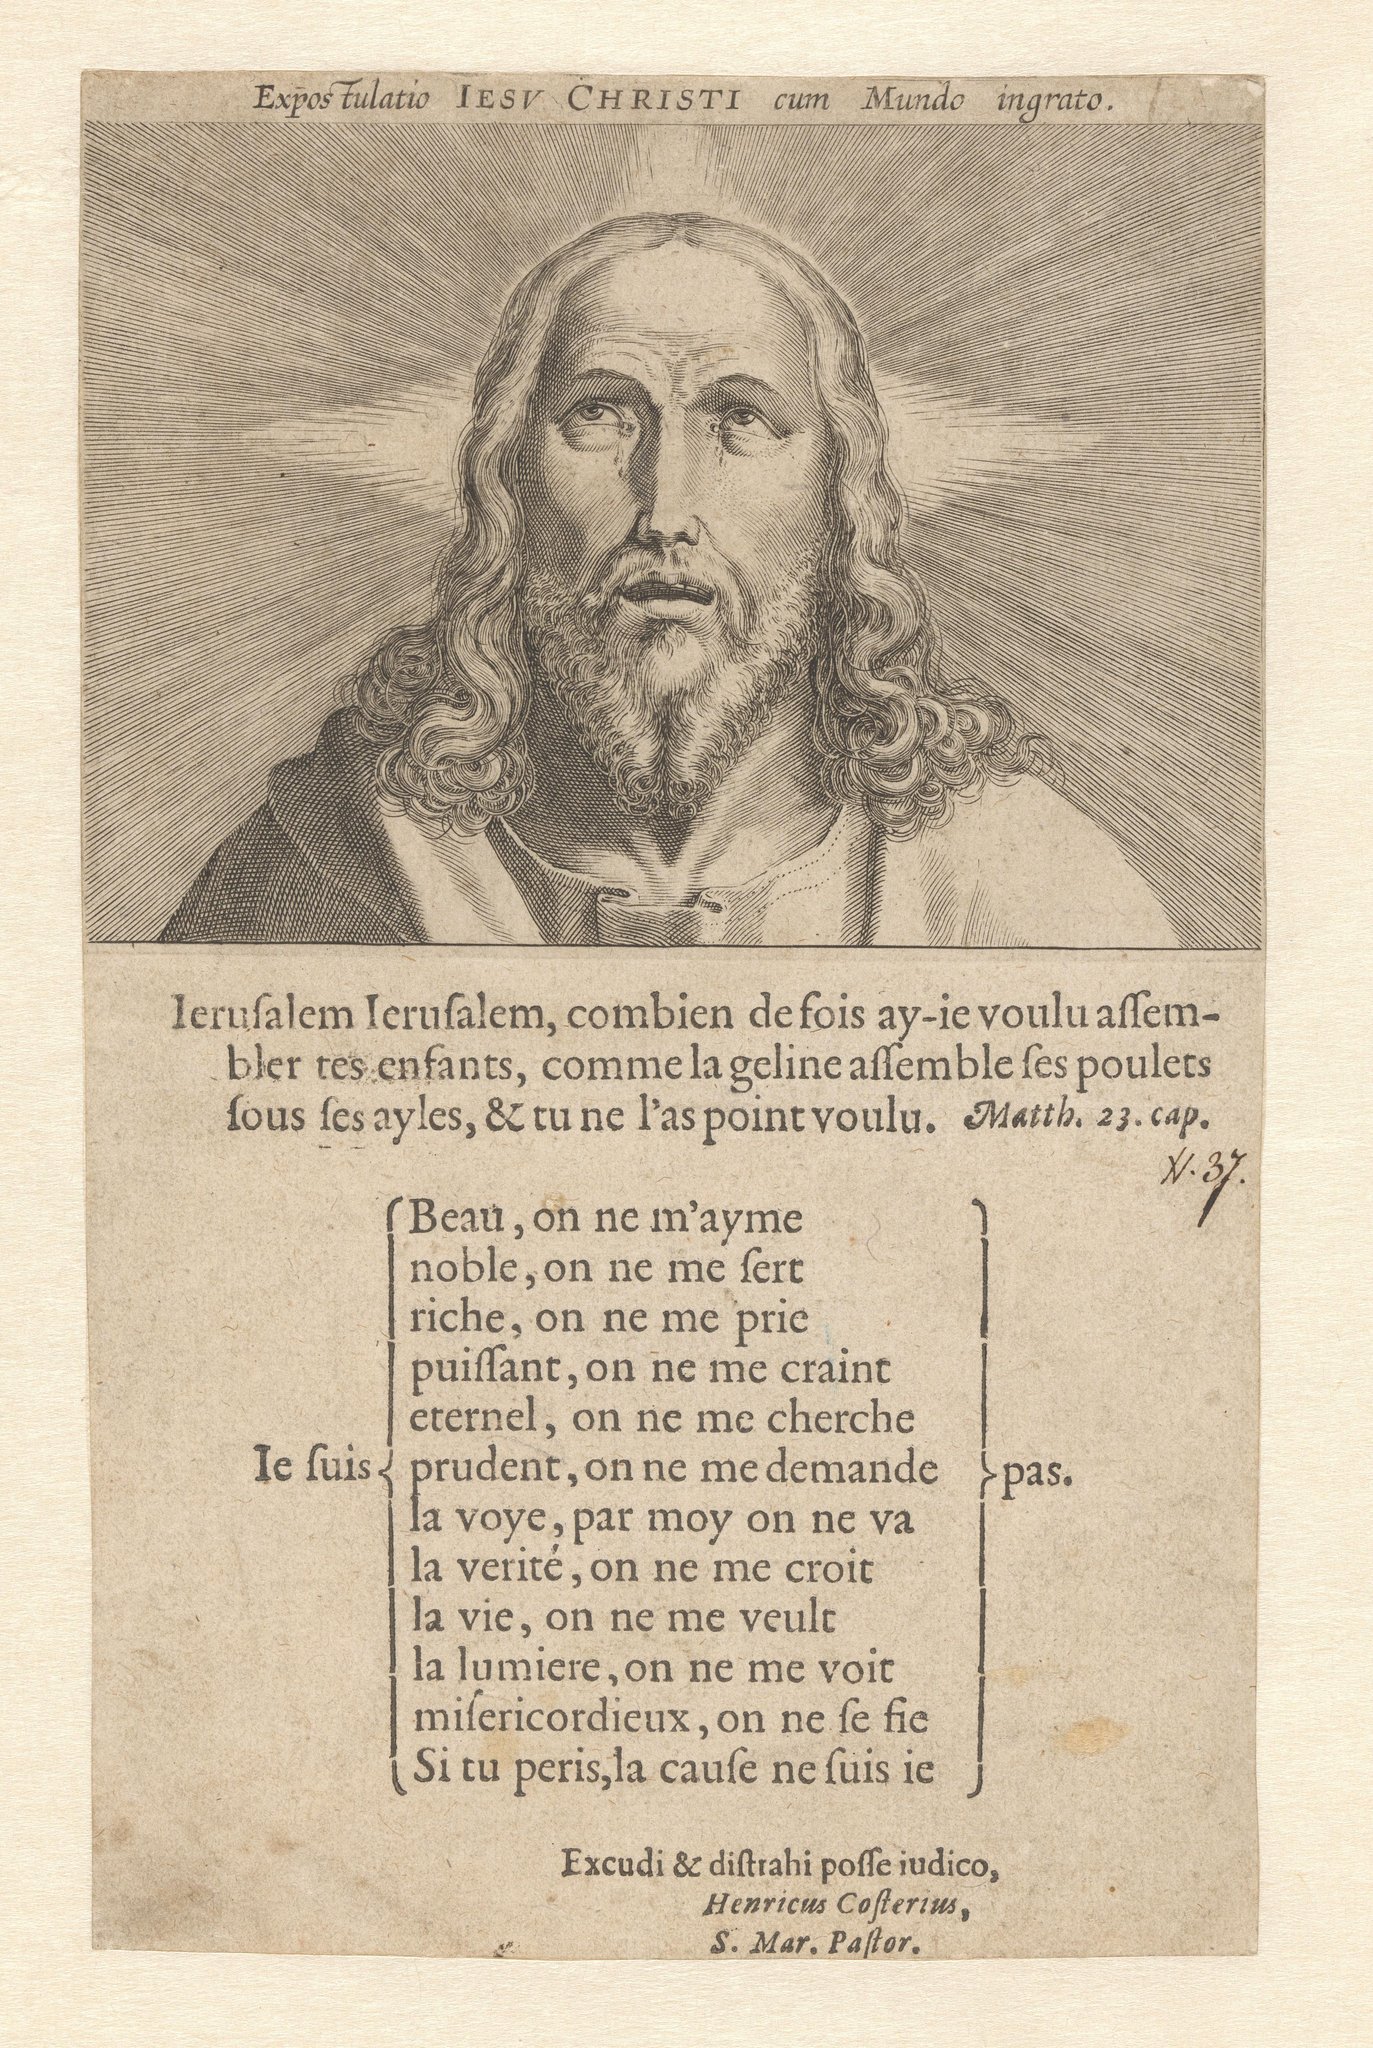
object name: print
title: Christuskop met gebed eronder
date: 1575-1600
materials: ink, paper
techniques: engraving, letterpress printing